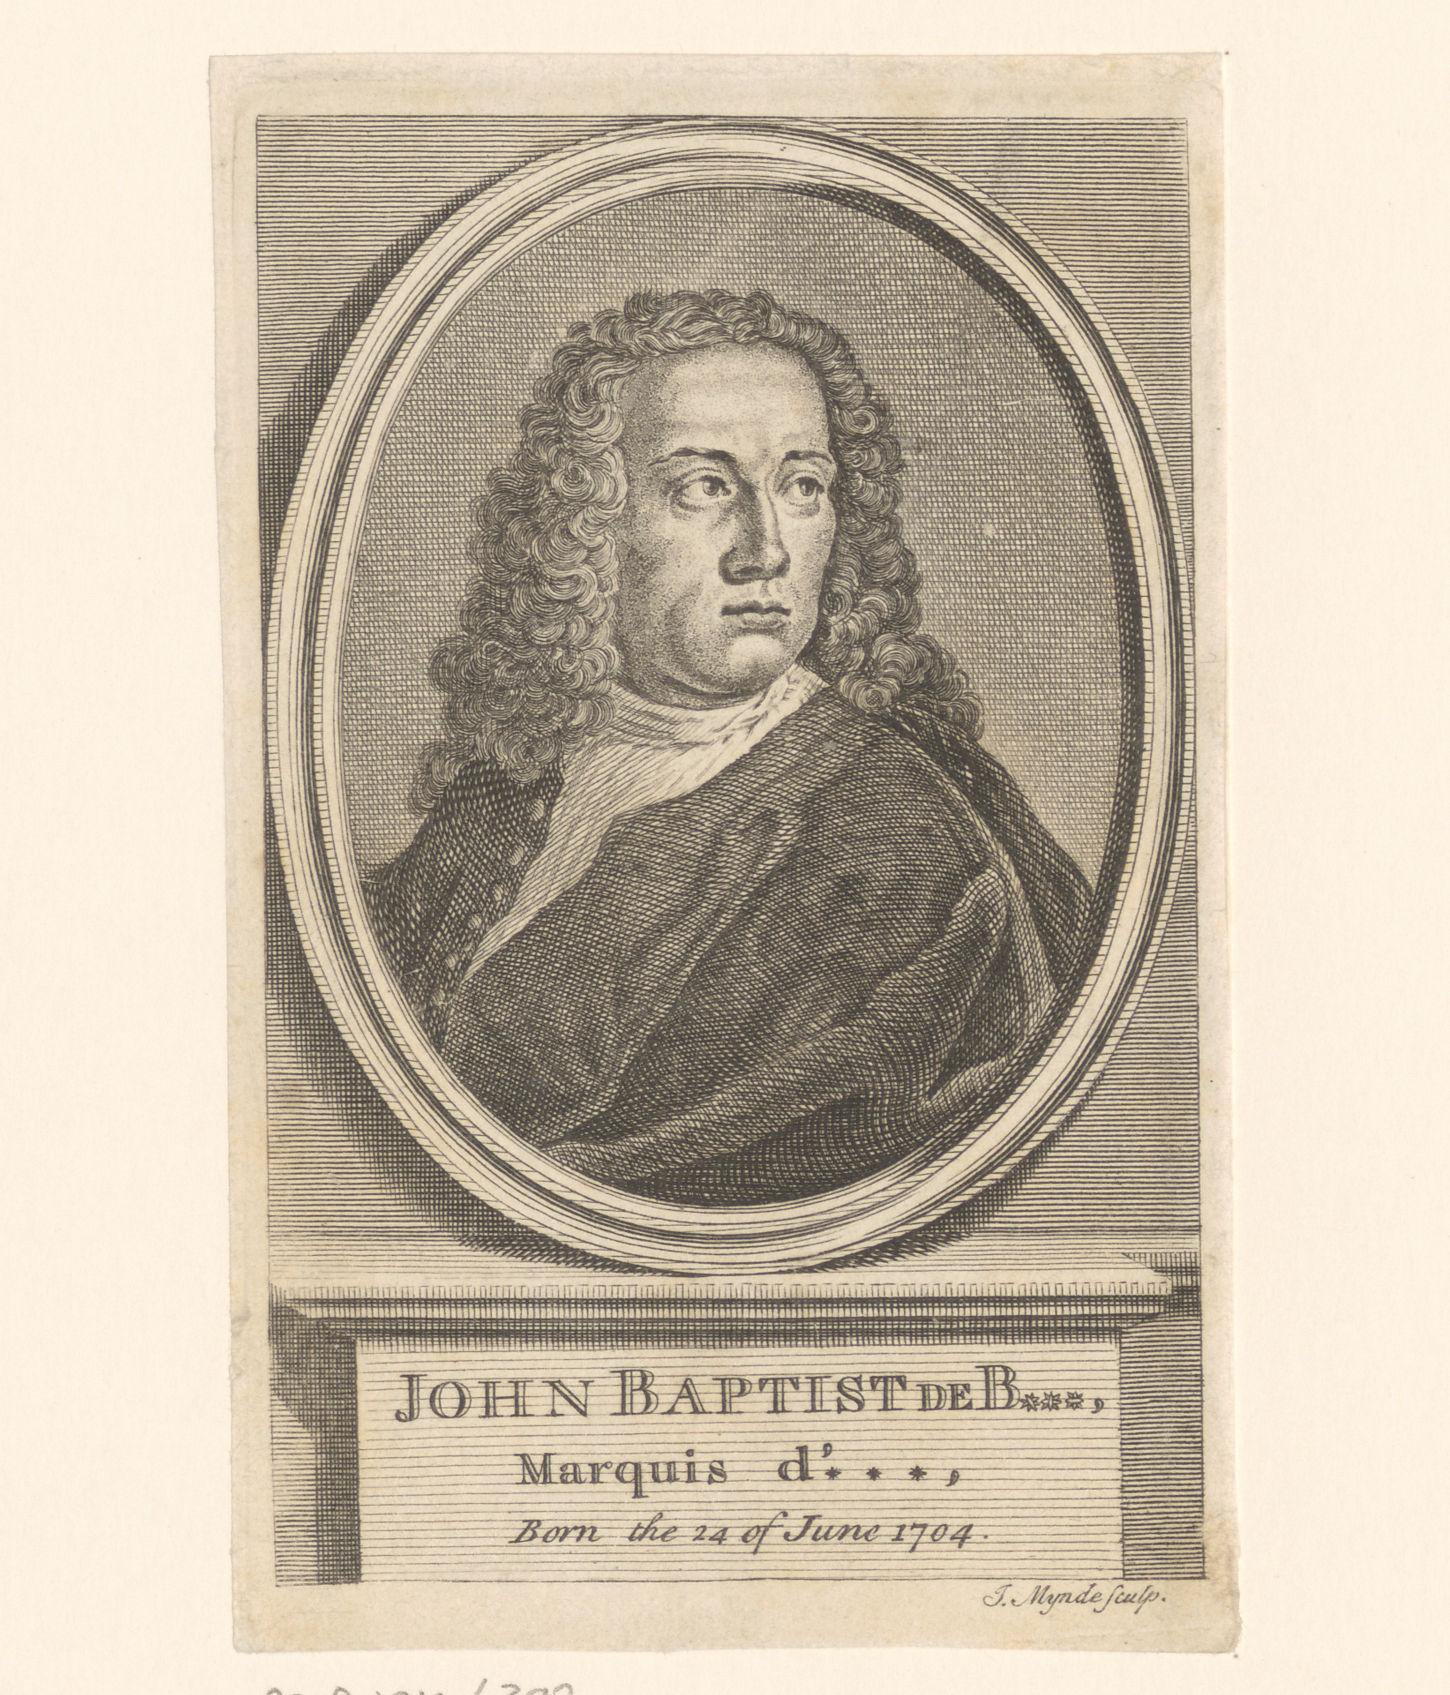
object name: print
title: John Baptist de B., Marquis de'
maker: james mynde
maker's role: print maker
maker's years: 1702-1771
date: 1738-1771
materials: paper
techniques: engraving, etching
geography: england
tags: toulon, historical persons, portrait of a writer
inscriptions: collector's mark: Lugt 2228